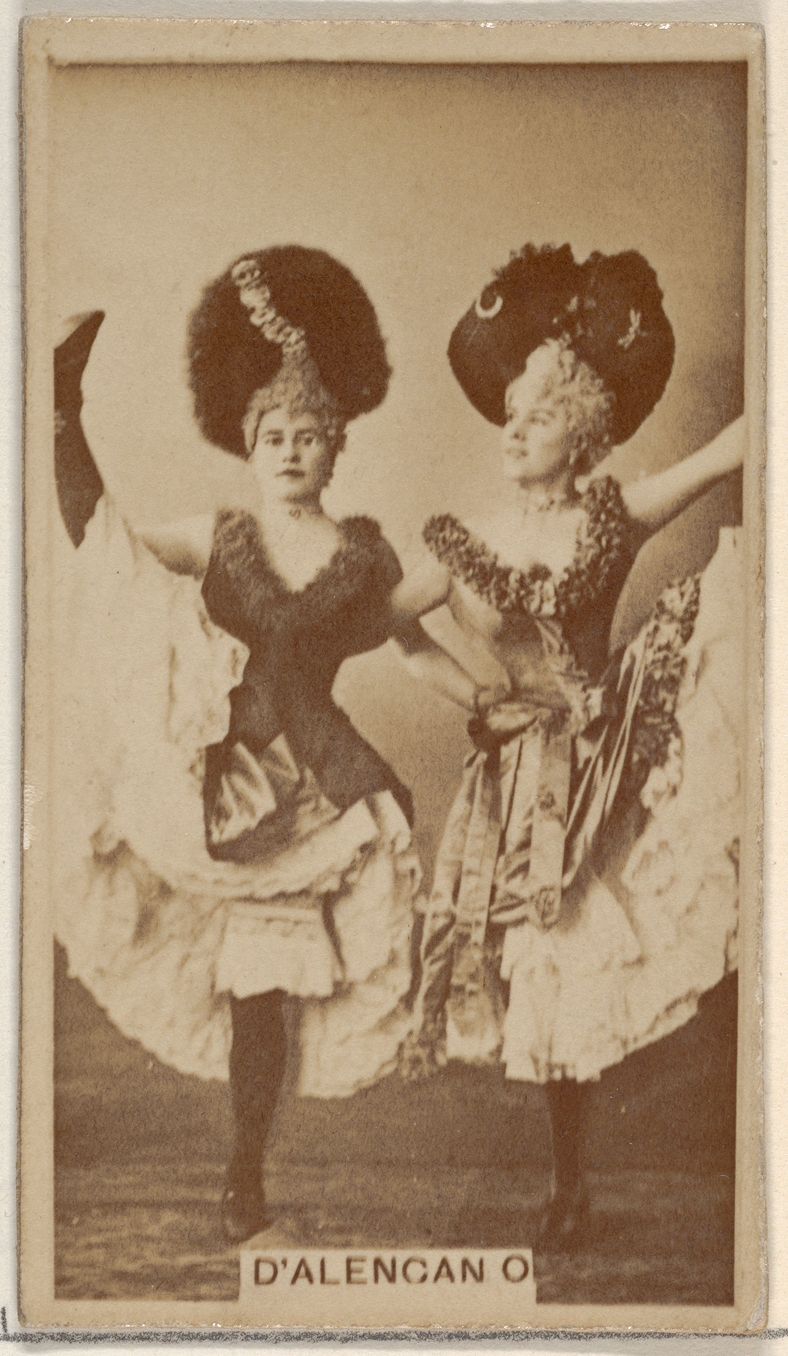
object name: photograph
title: D'Alencan, from the Actors and Actresses series (N45, Type 8) for Virginia Brights Cigarettes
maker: allen & ginter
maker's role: publisher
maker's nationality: american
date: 1888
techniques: albumen silver print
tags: portraits,women,actresses,dancers